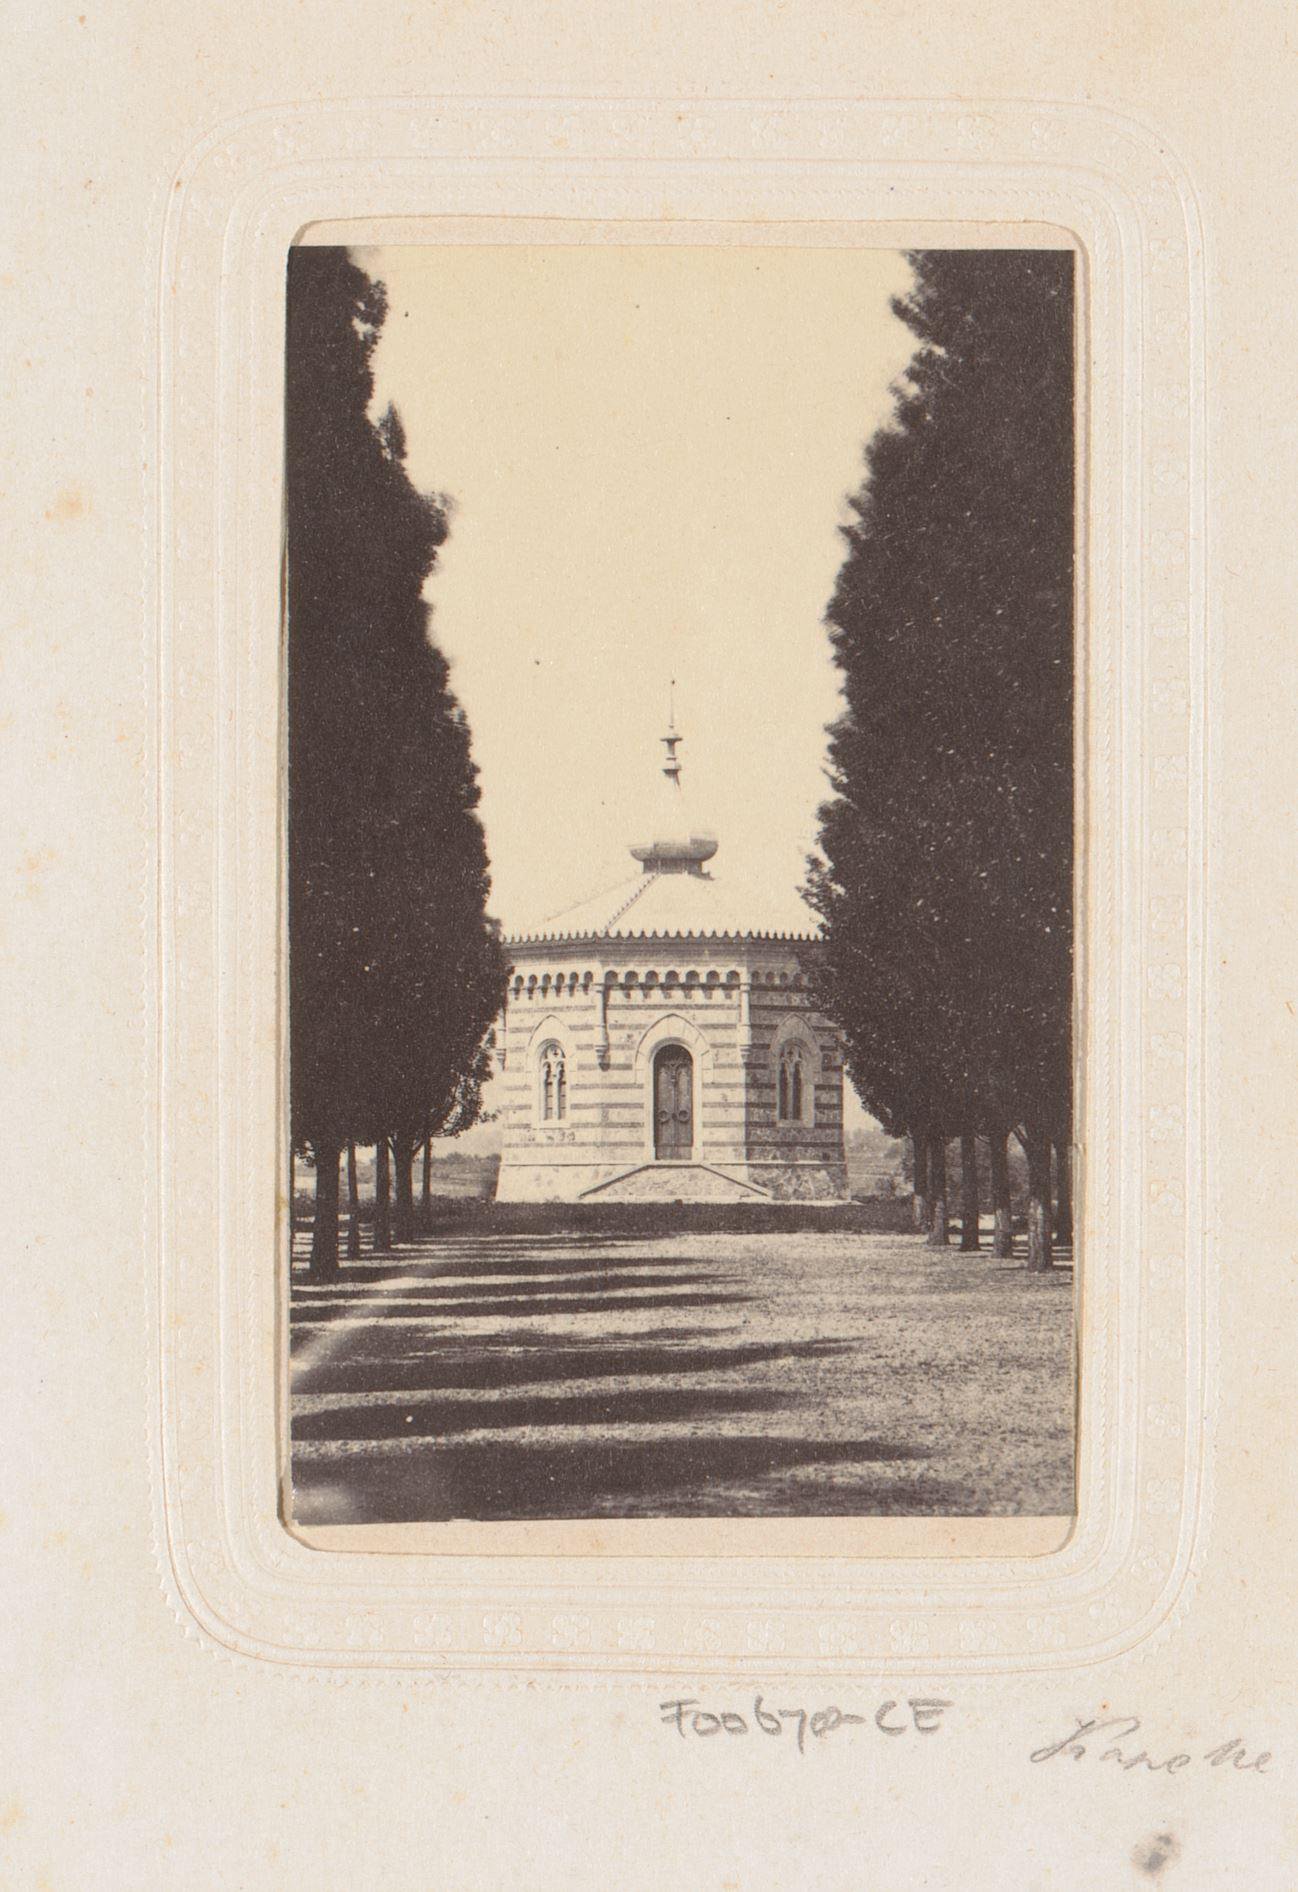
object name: album leaf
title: Gezicht op een kapel te Băile Herculane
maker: Anonymous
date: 1860-1880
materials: cardboard, photographic support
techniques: albumen print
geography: băile herculane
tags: parts of church exterior and annexes: chapel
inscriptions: annotation: ‘Kappelle der ungarische KronungsKleinodien bei Onsova’, annotation: ‘35nx.’